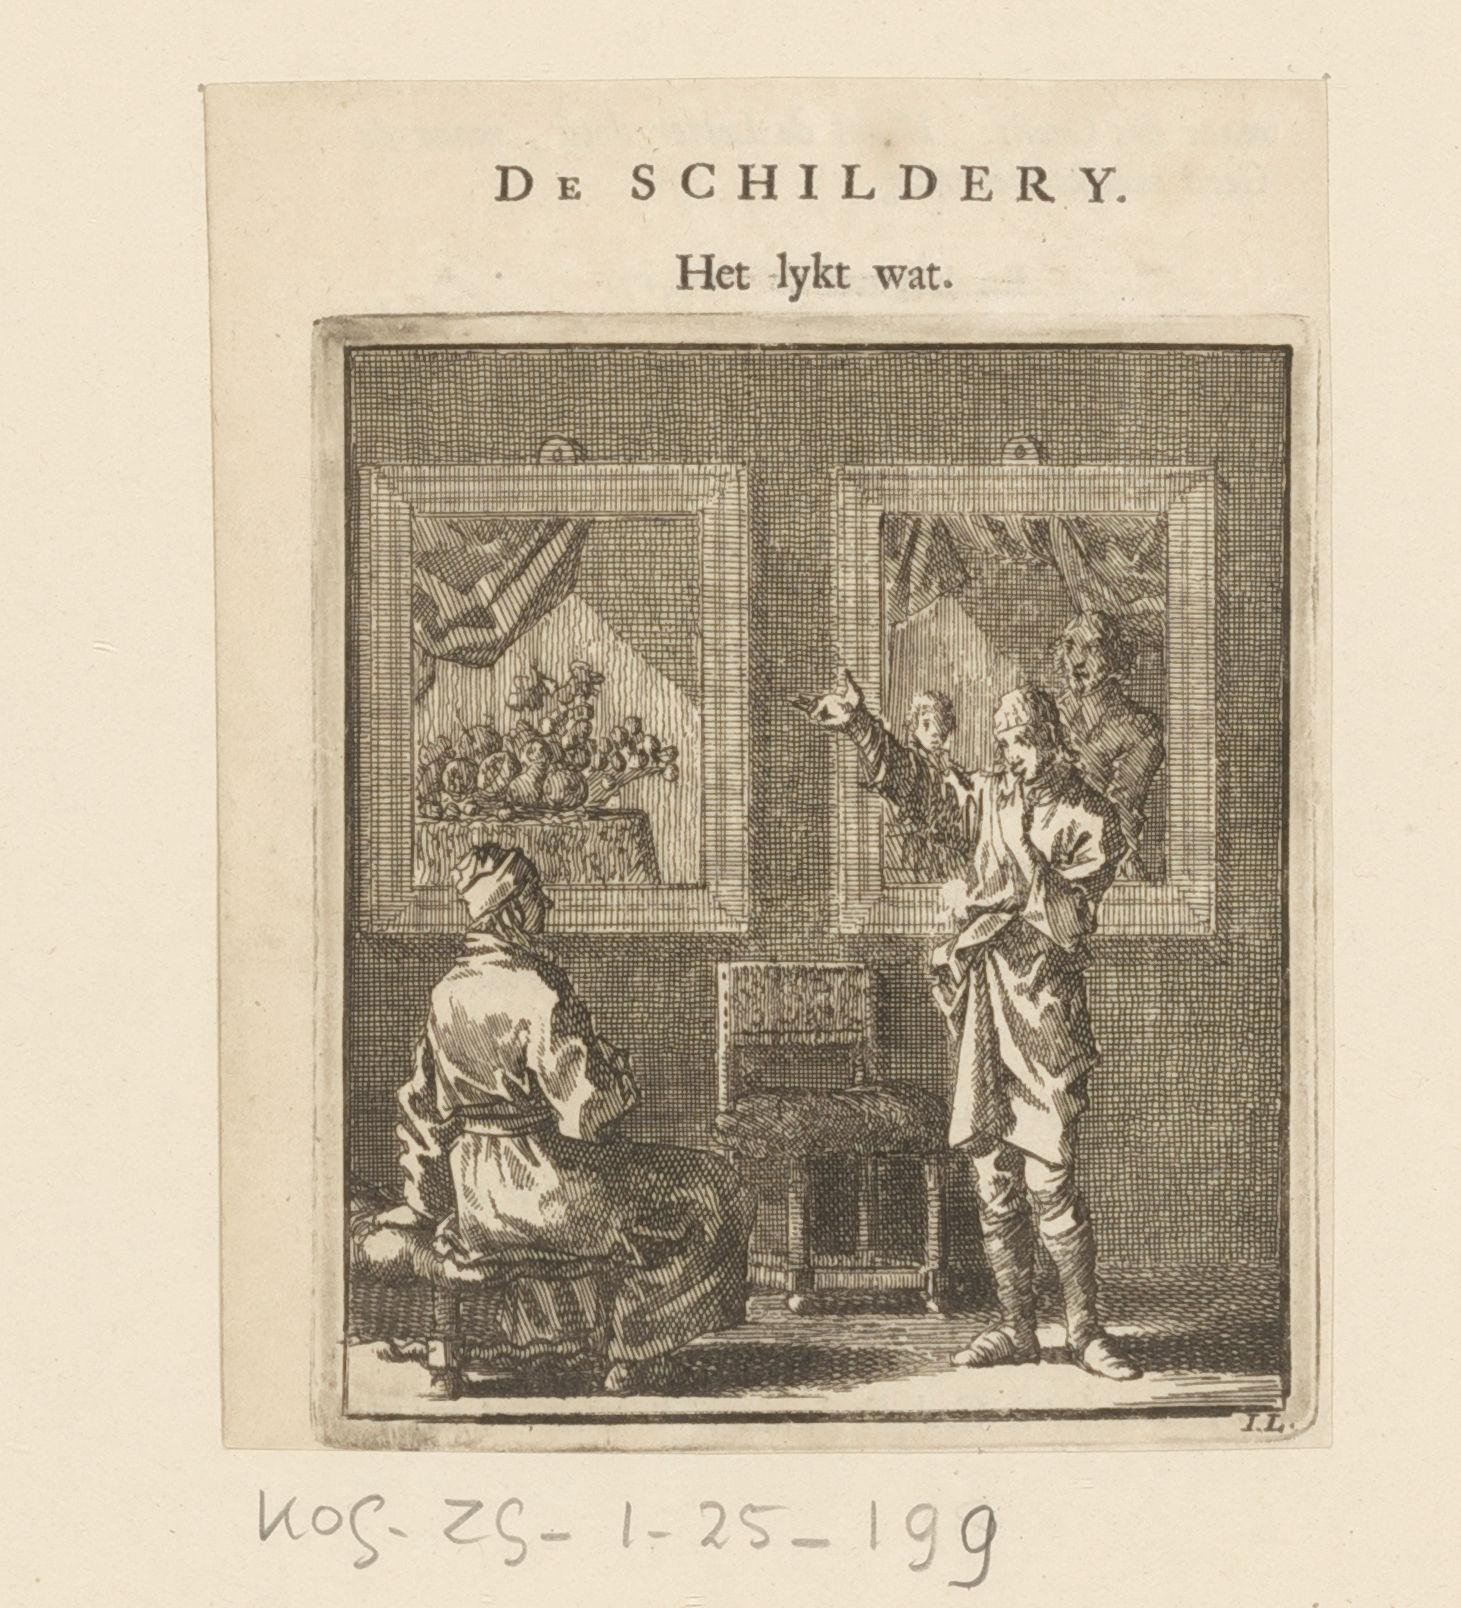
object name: print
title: Jongeman vertelt over de schilderijen die achter hem hangen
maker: jan luyken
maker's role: draughtsman, print maker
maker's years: 1649-1712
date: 1711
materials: paper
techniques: etching, letterpress printing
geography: amsterdam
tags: picture within picture, picture, painting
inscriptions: collector's mark: Lugt 1641, stamp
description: Prent uit: Luyken, Jan. Het leerzaam huisraad, vertoond in vyftig konstige figuuren, met godlyke spreuken en stichtelyke verzen. Amsterdam: weduwe Pieter Arentsz. II en Cornelis van der Sys, 1711, p. 68.